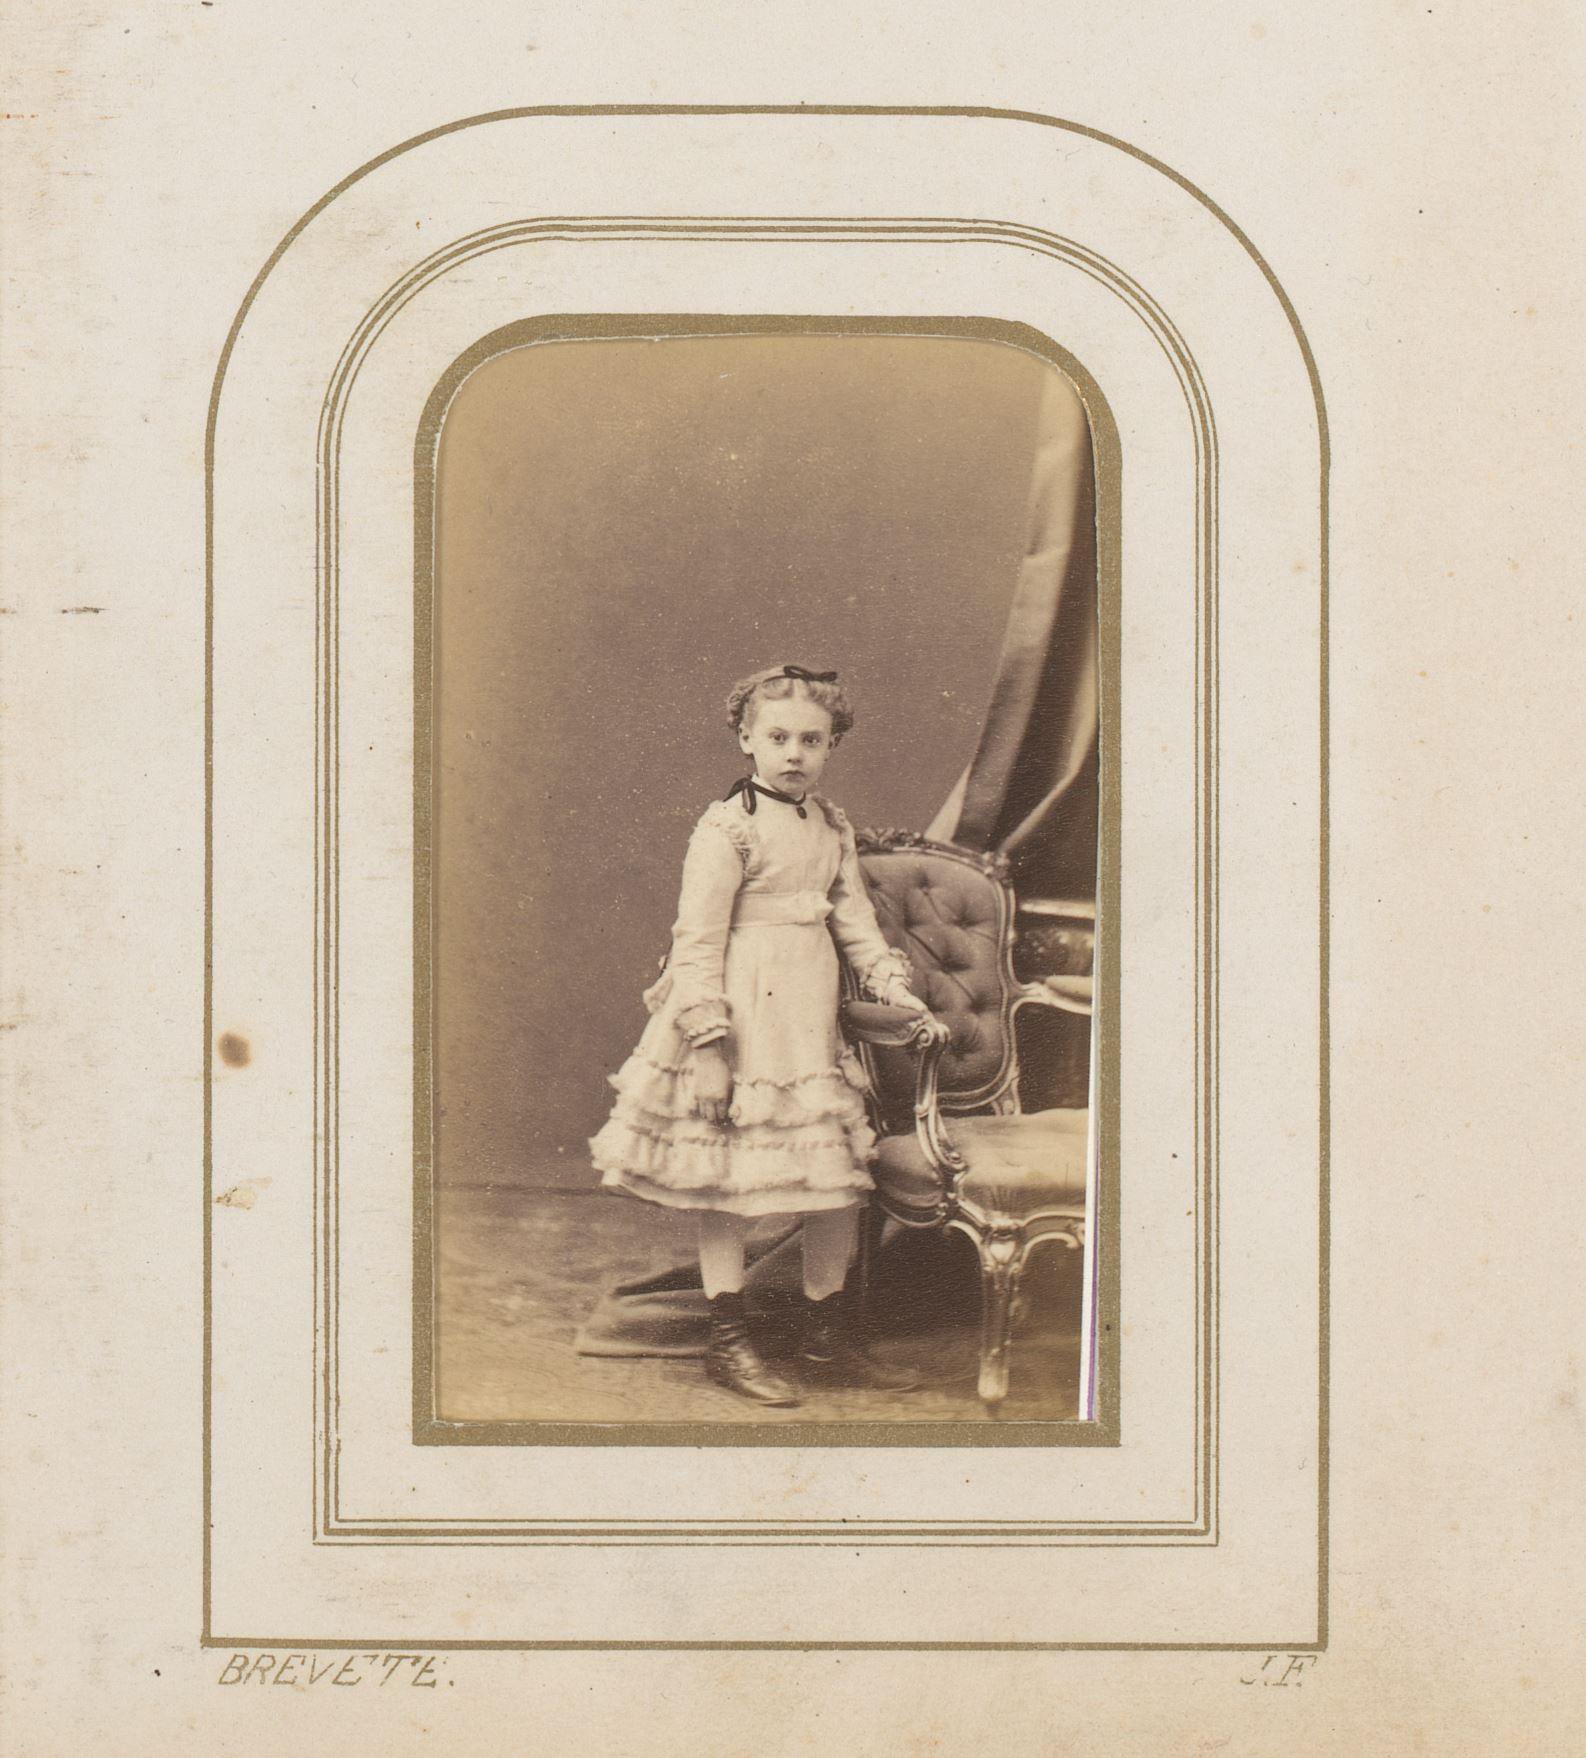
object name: album leaf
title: Portret van een meisje, staand bij een stoel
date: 1866-1890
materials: cardboard, photographic support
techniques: albumen print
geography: brussels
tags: historical persons - bb - woman, girl (child between toddler and youth)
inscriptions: inscription: ‘Géruzet Frères/ photographes/ 27bis Rue de l'Ecuyer/ Bruxelles’